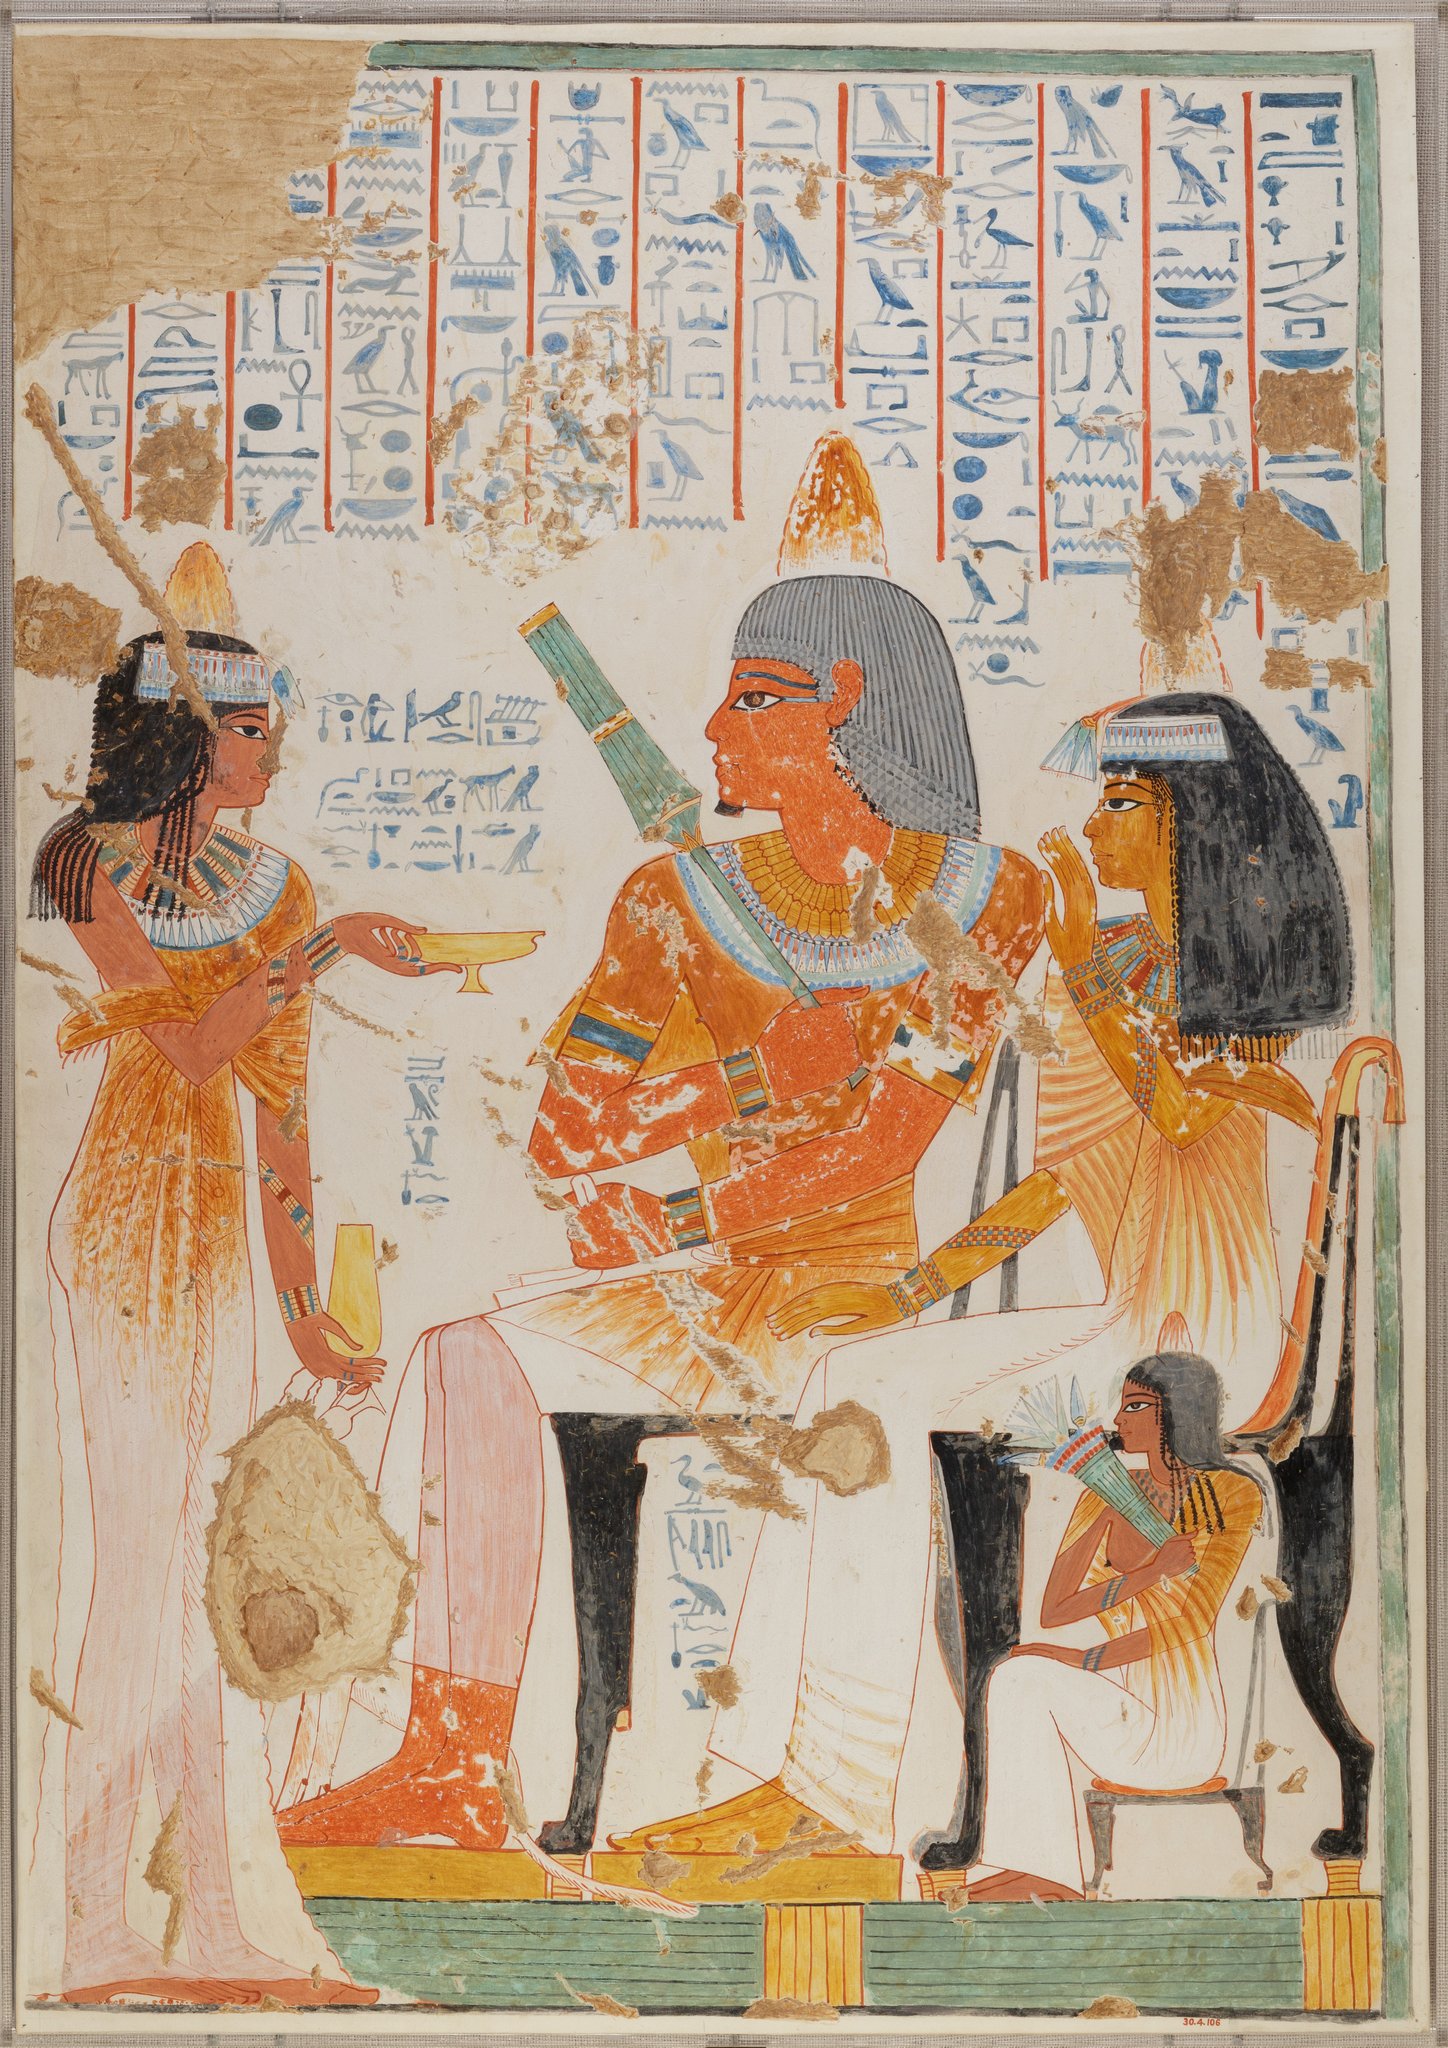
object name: facsimile, nebamun, ipuky tt 181, offering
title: Nebamun Receiving Wine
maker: nina de garis davies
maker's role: artist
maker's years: 1881-1965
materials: paper, paint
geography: egypt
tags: wine,men,women,hieroglyphs,drink-and-be-merry